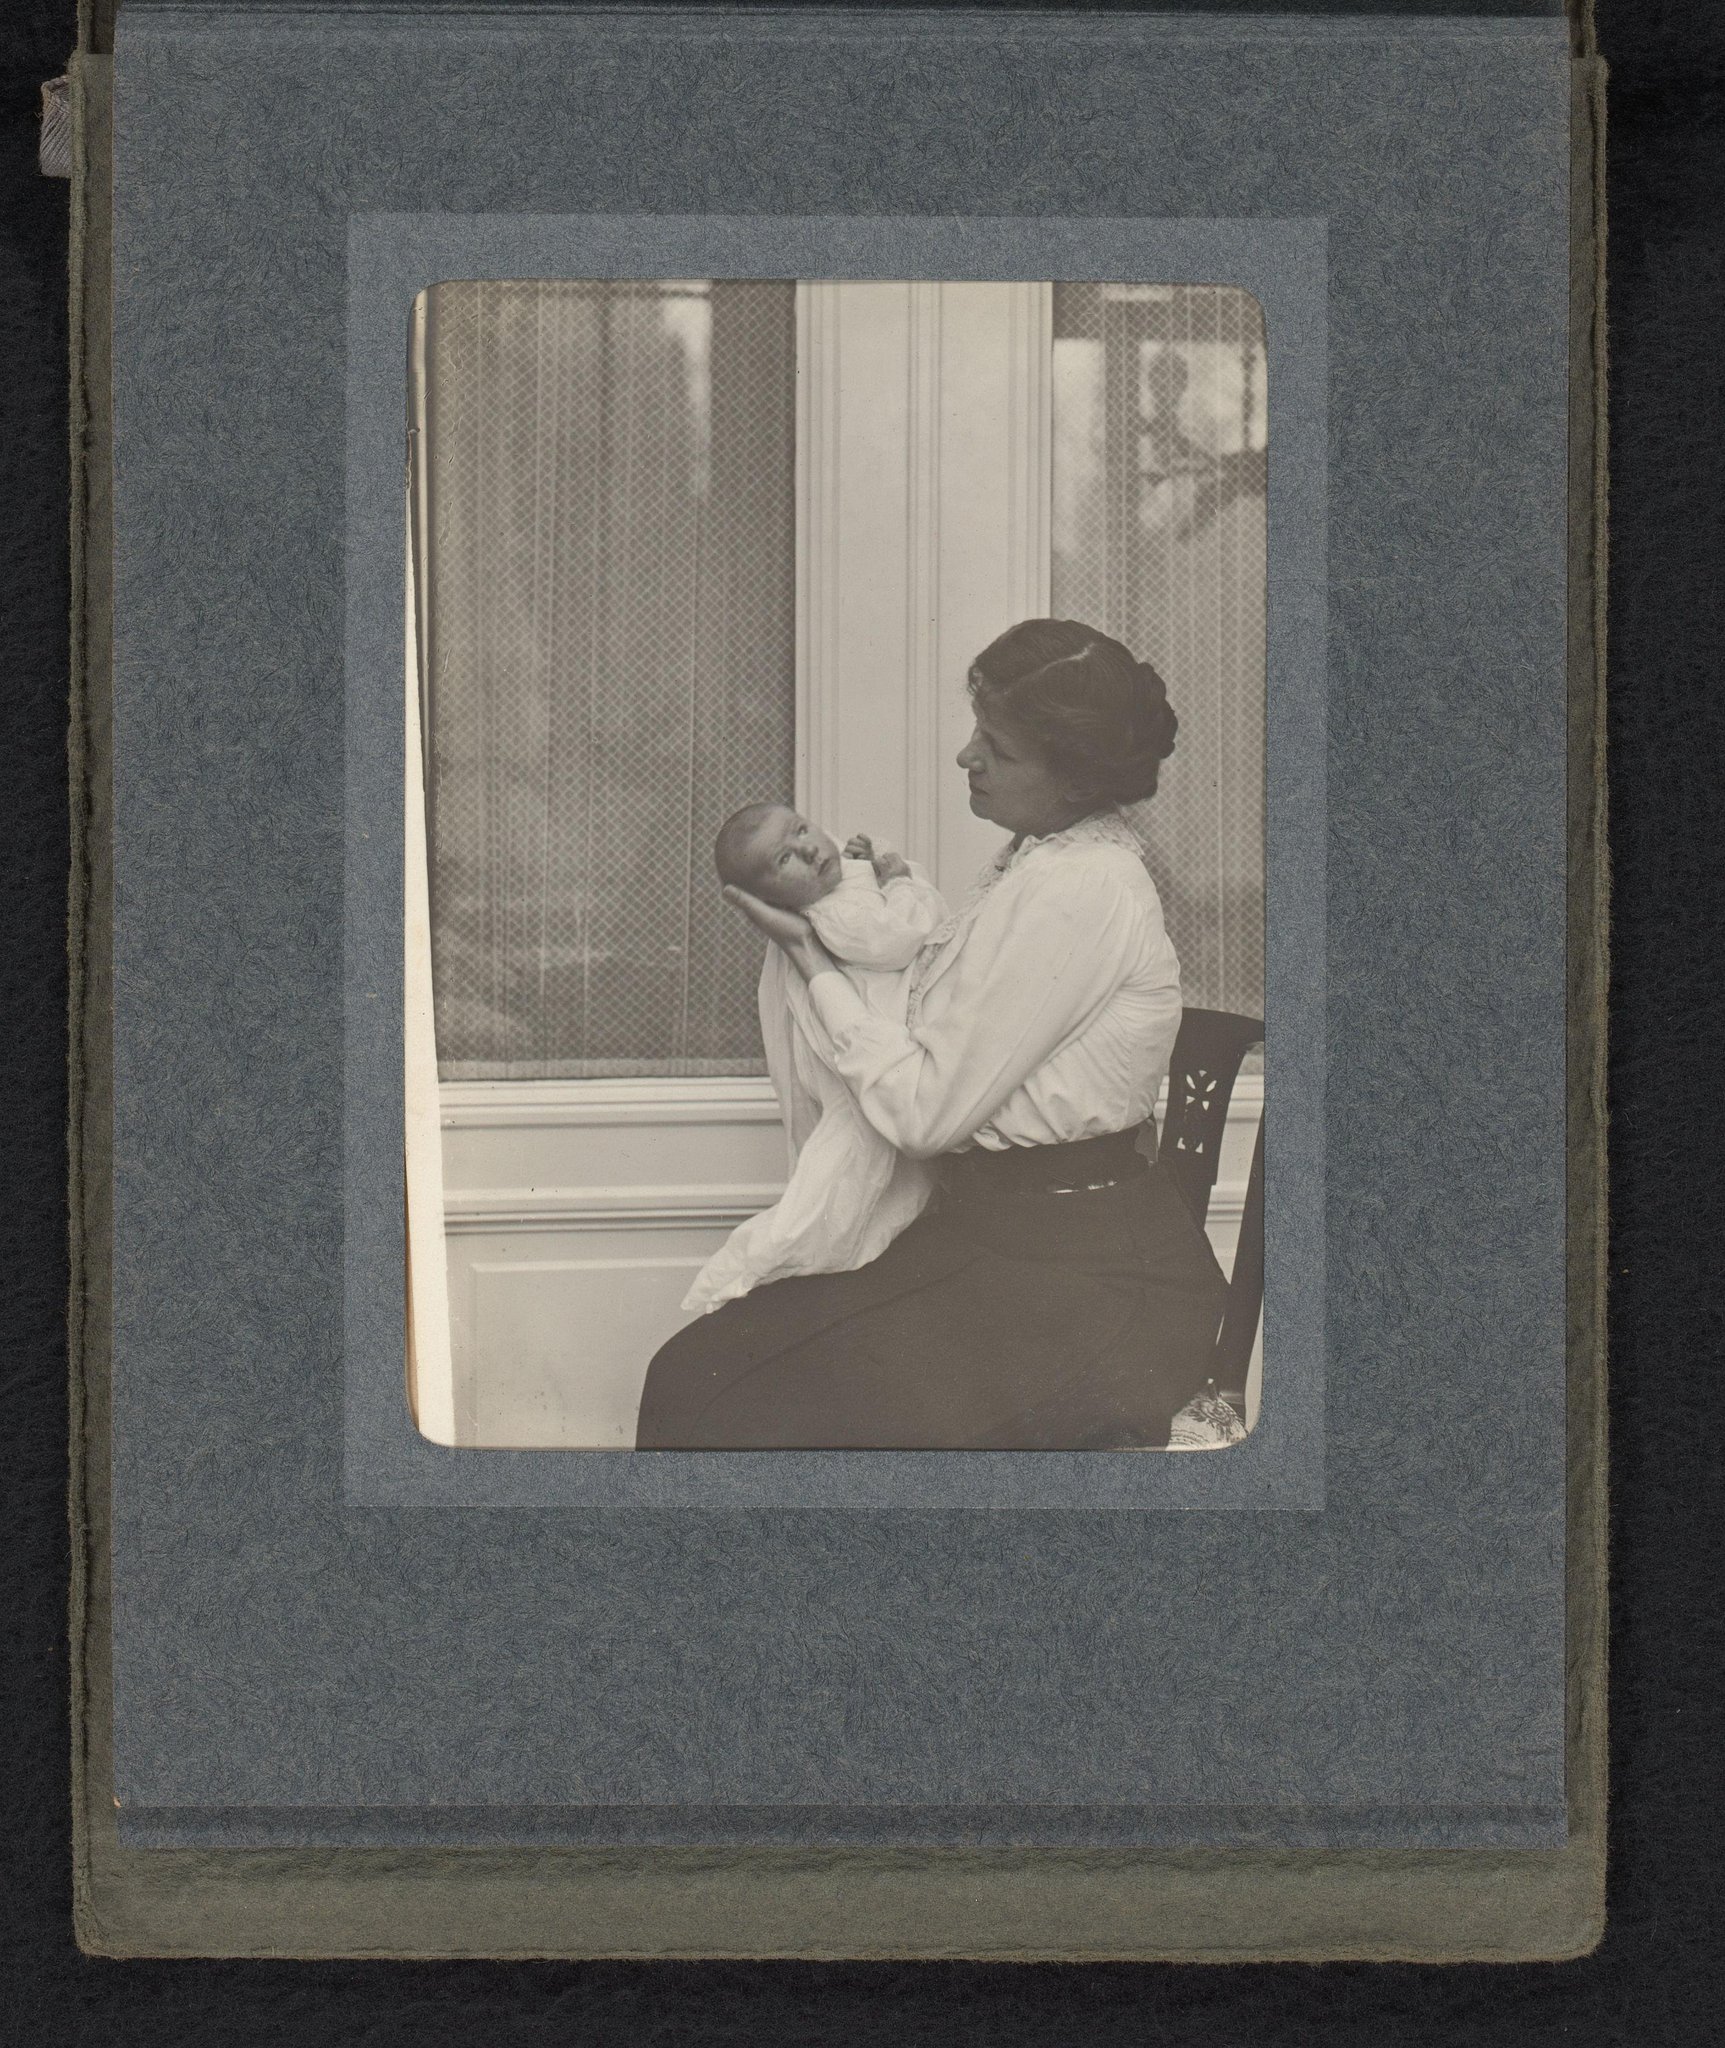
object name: photograph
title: Caroline van den Berg met baby Frank in haar armen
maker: hendrik herman van den berg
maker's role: amateurfotograaf, jurist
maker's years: 1875-1944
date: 1912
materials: paper, cardboard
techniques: gelatin silver print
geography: amsterdam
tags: the hague, caroline louise van den berg-van den berg, amsterdam, frank willem van den berg (1912-1998), historical persons, mother and baby or young child, infant, baby